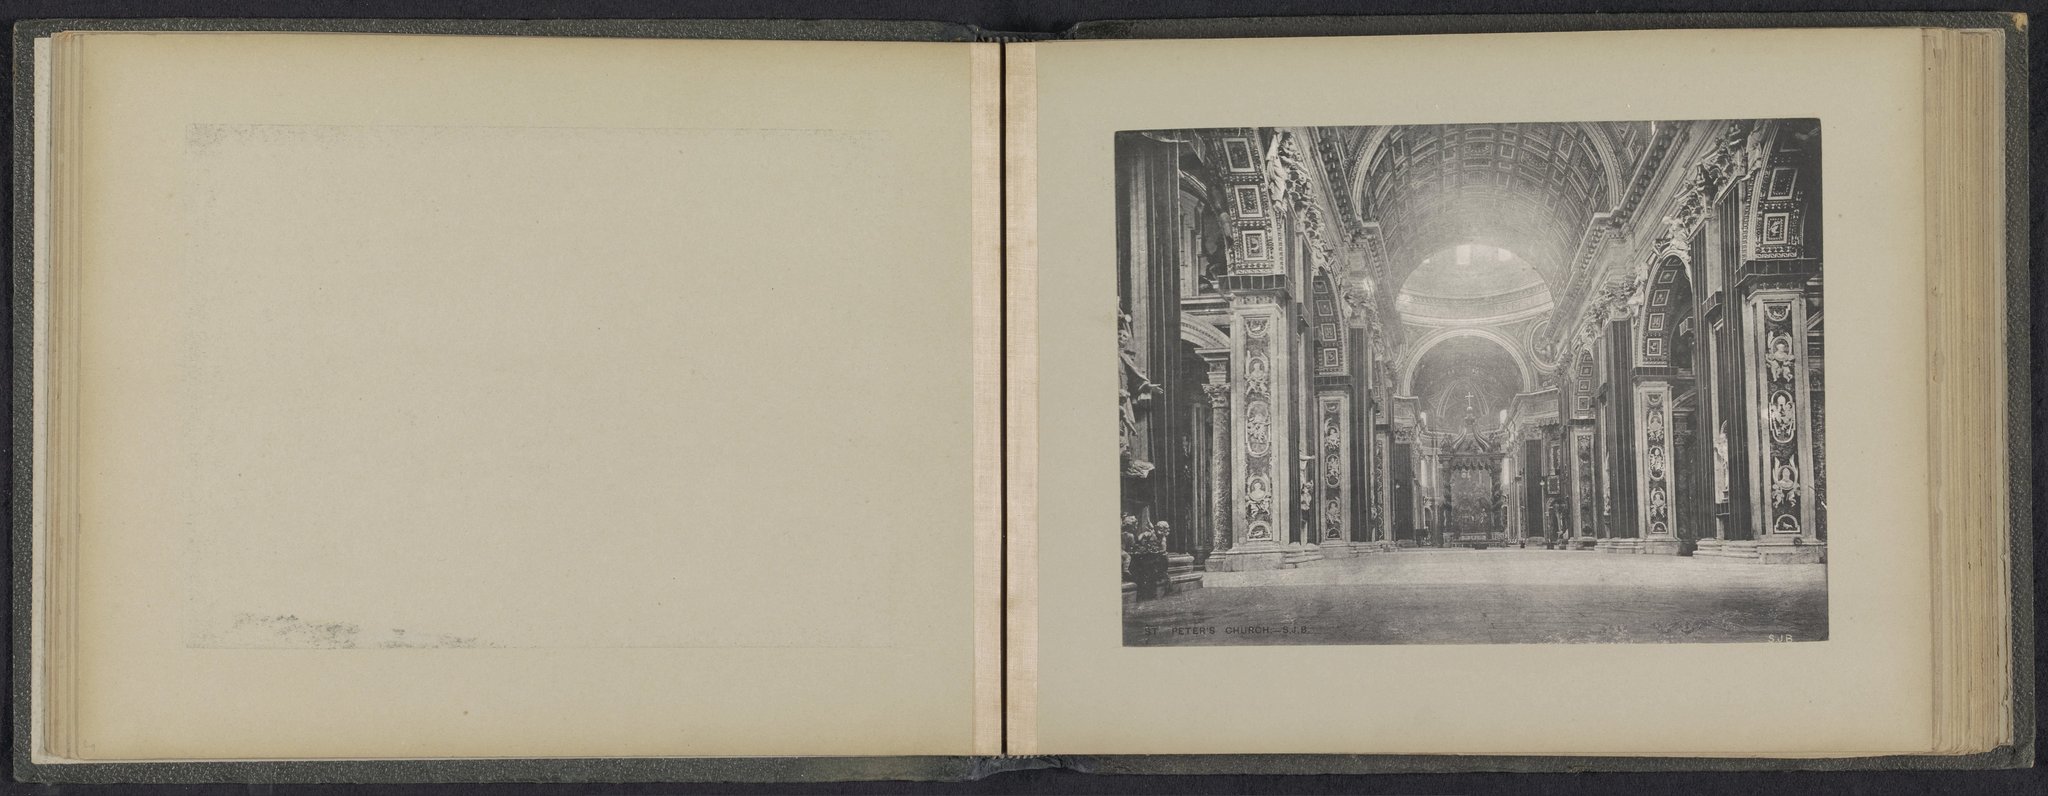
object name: photomechanical print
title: St. Peter's church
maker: samuel j. beckett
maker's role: fotograaf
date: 1890-1900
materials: paper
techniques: photograph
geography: sint-pietersbasiliek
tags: parts of church interior: aisle, interior of church